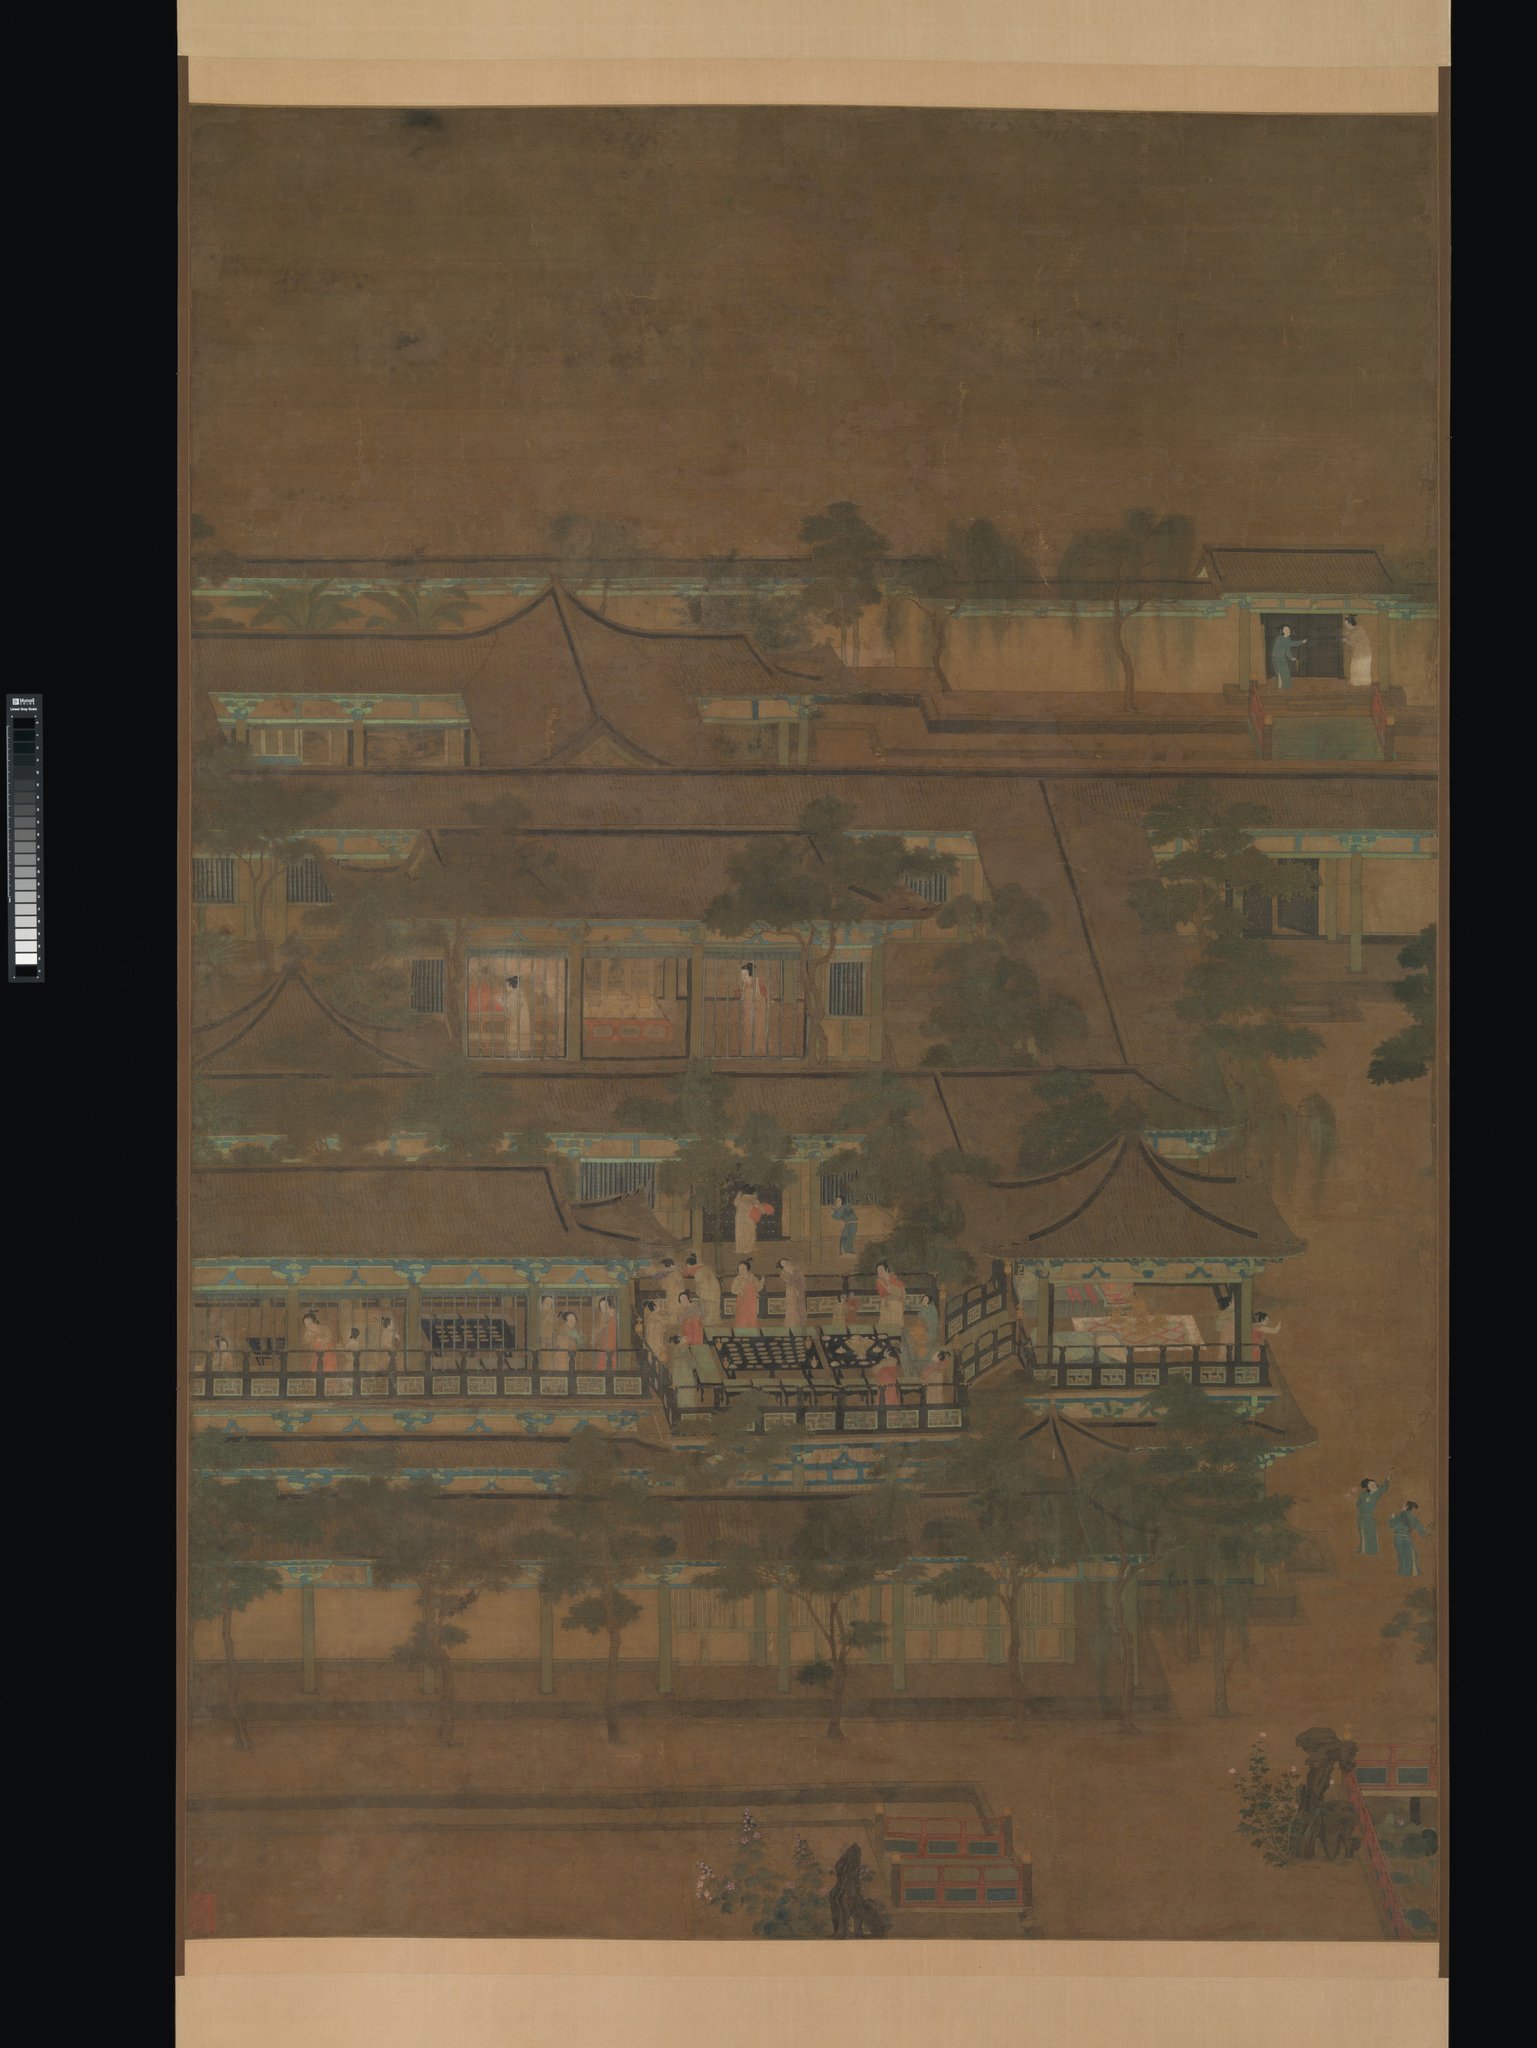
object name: hanging scroll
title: Palace banquet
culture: chinese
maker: unidentified artist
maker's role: artist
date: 967-1000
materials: ink, silk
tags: food,palaces,women,banquets